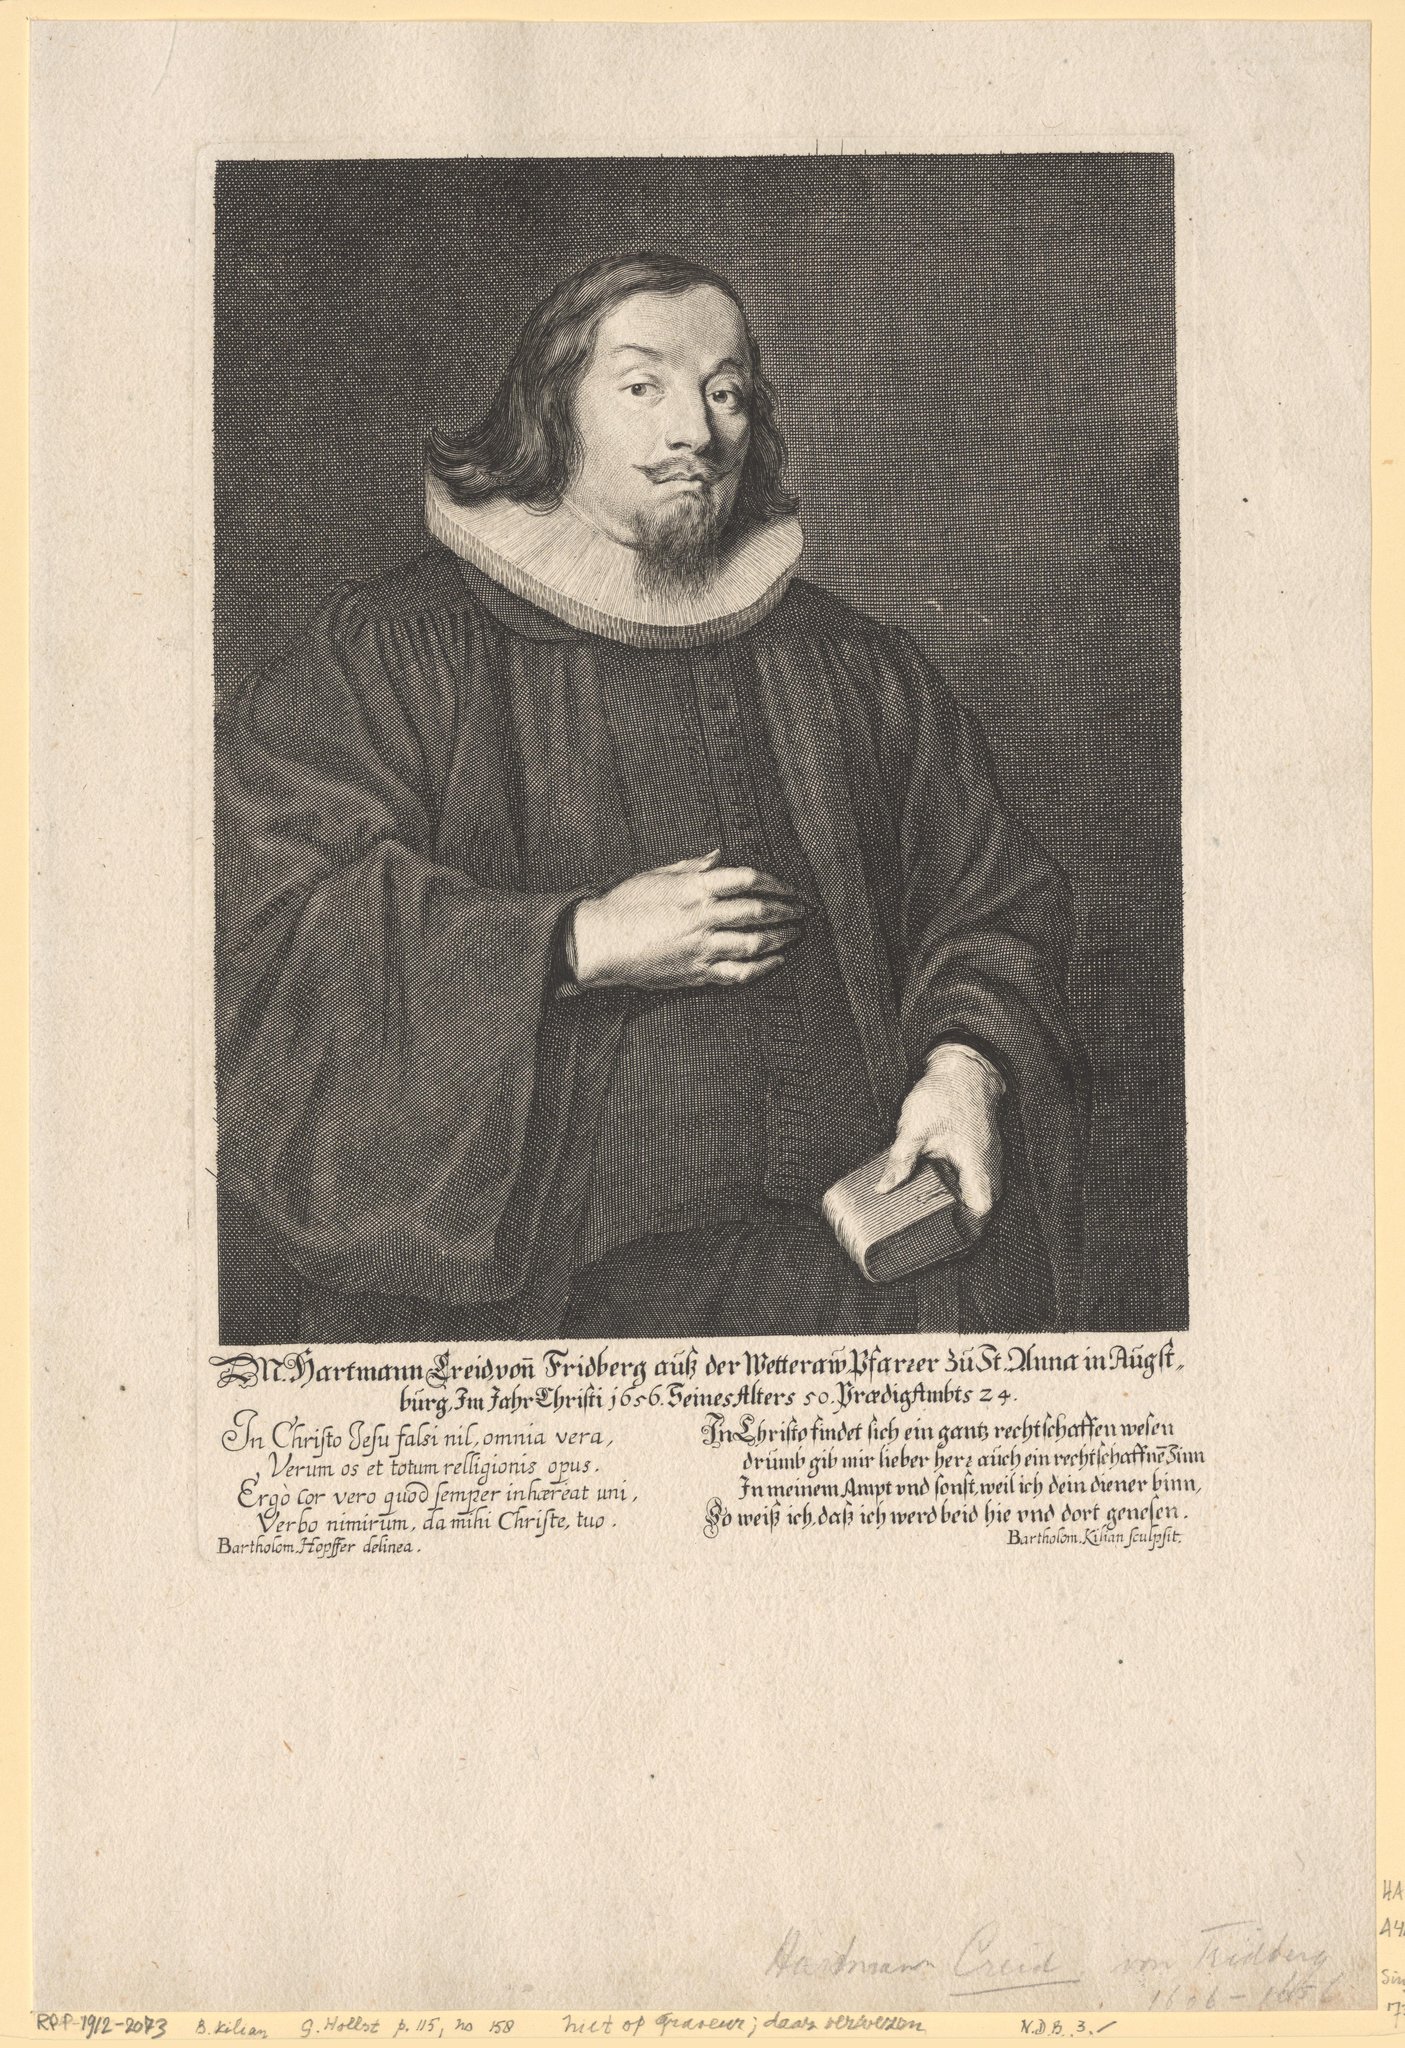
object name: print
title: Portret van Hartmann Creide op 50-jarige leeftijd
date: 1656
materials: paper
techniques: engraving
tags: historical persons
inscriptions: date